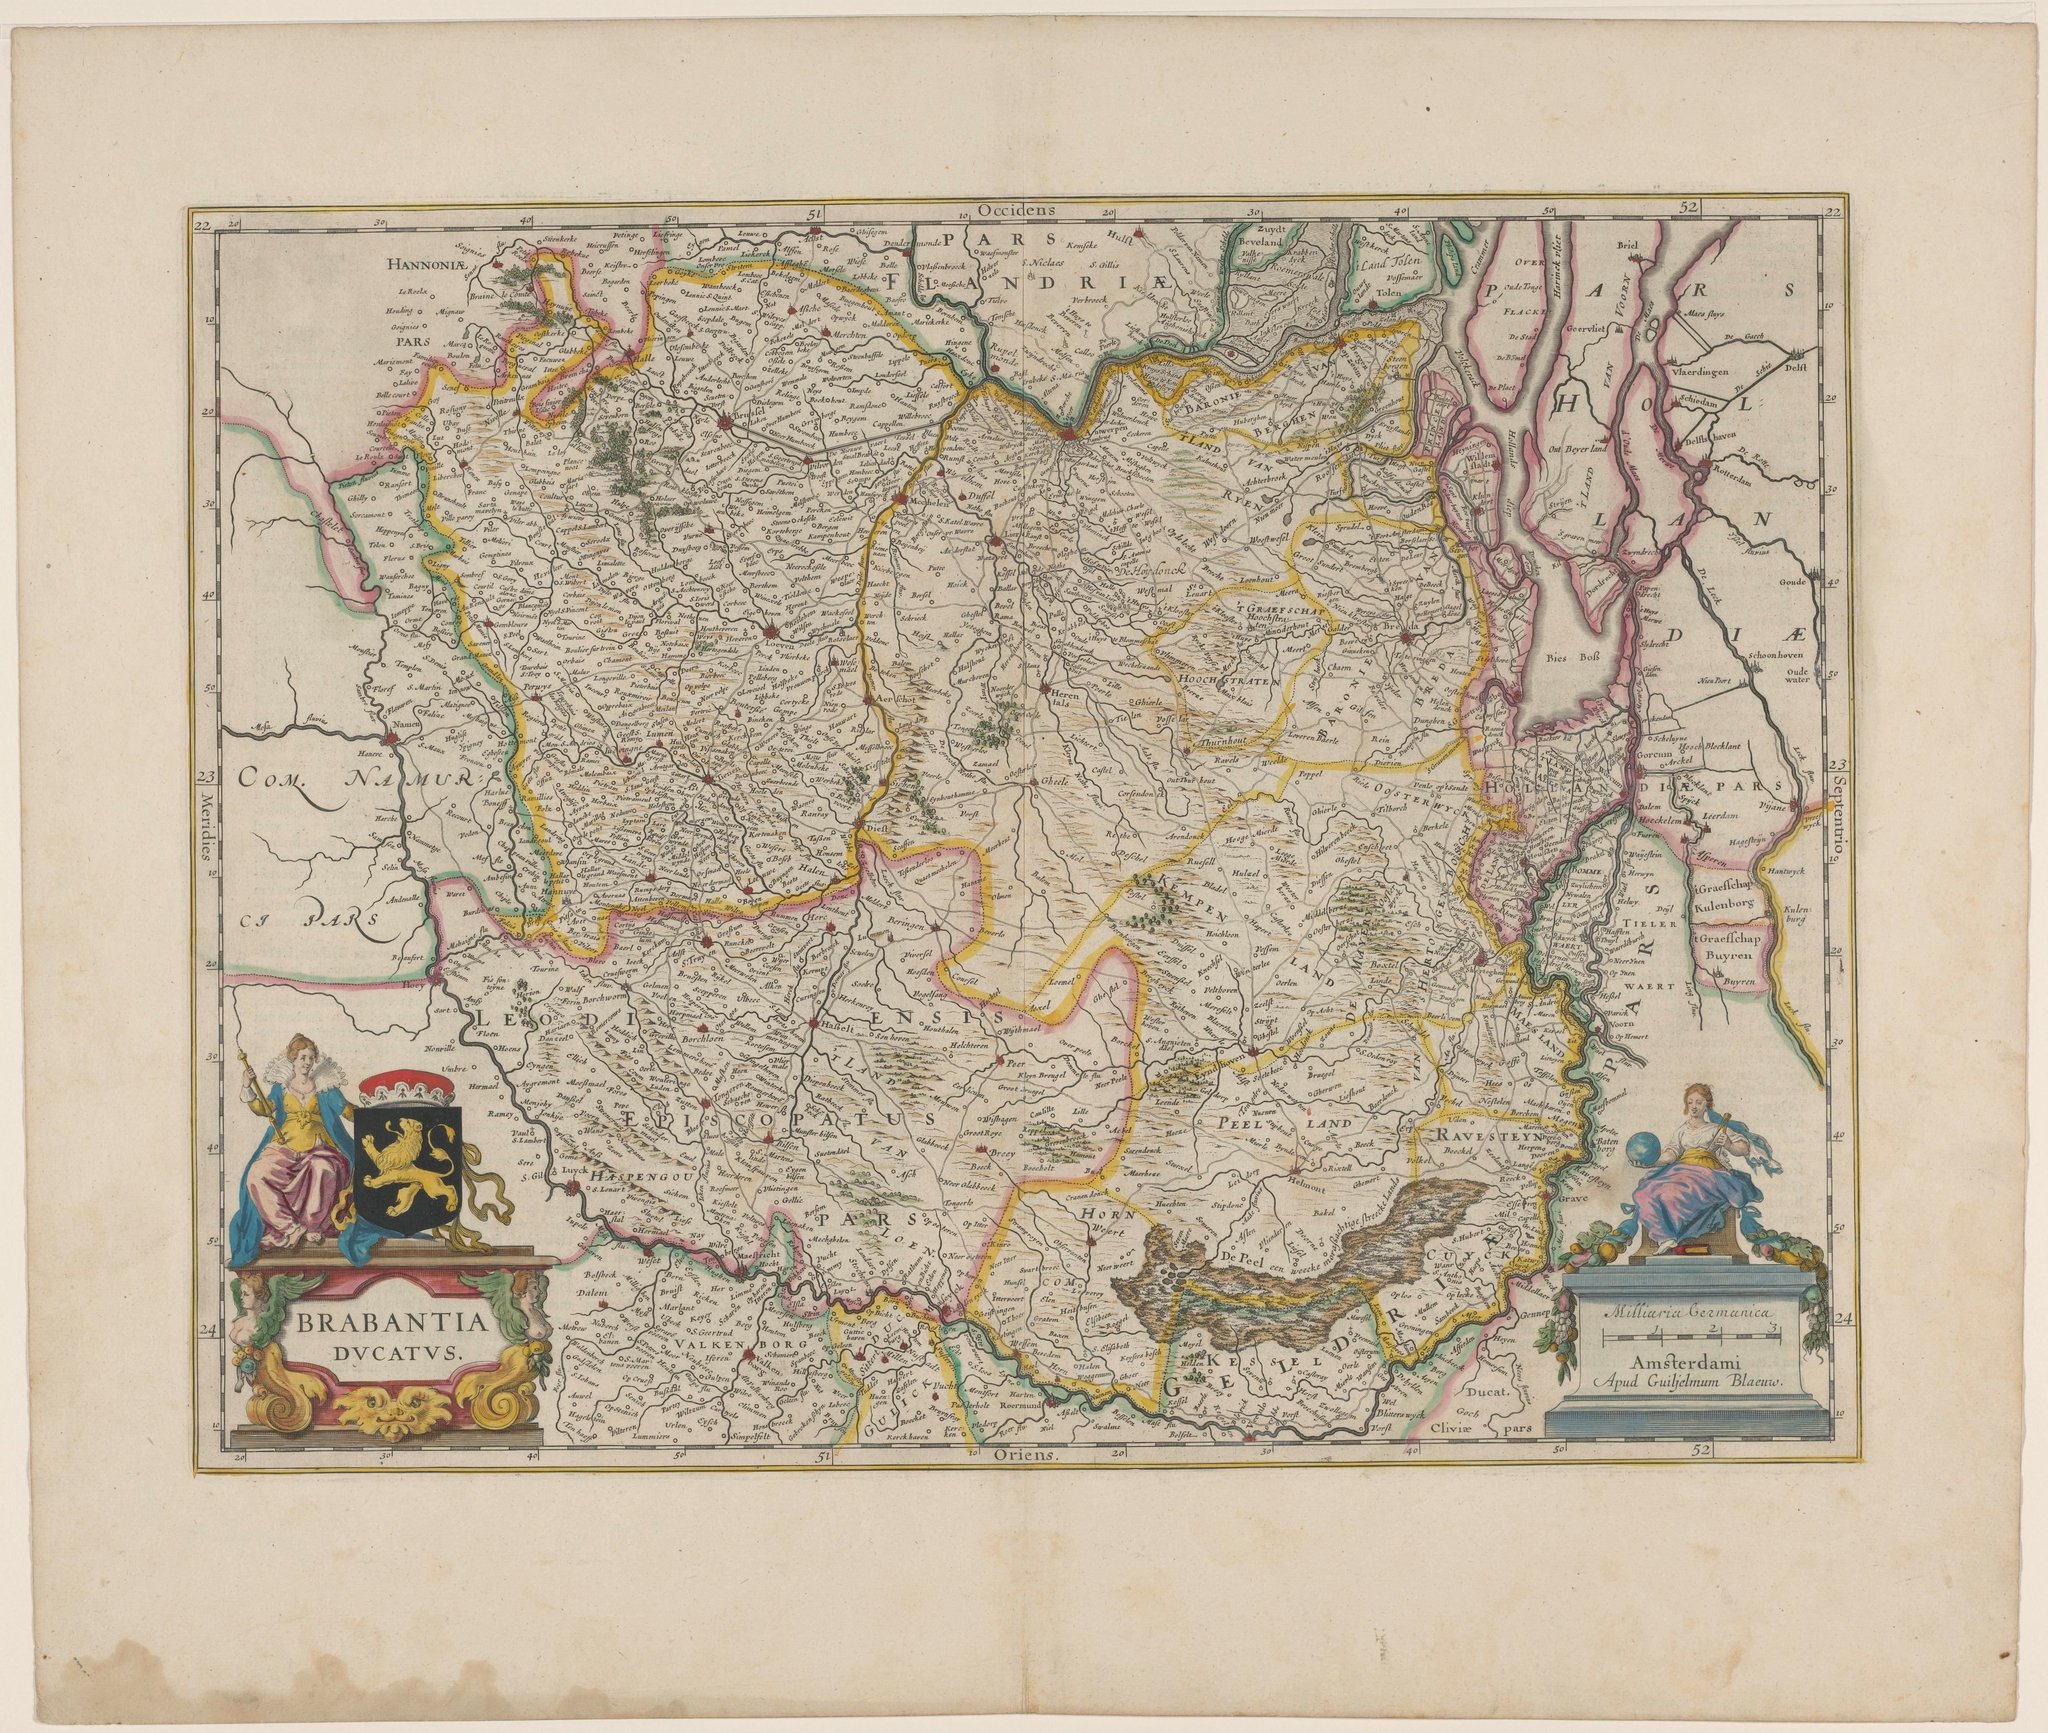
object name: print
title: Kaart van het hertogdom Brabant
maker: Anonymous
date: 1635-1664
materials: paper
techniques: engraving, etching, hand coloring, letterpress printing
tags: maps of separate countries or regions, coat of arms (as symbol of the state, etc.) (+ province; provincial), brabant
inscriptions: collector's mark: Lugt 2228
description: Prent gebruikt in: Blaeu, Willem Janszoon en Johannes Willemszoon Blaeu. Toonneel des aerdriicx, ofte nieuwe Atlas, dat is de beschryving van alle landen. 2 delen. Amsterdam: Willem Janszoon en Johannes Willemszoon Blaeu, 1635, dl. 1. Of in: Blaeu, Willem Janszoon en Johannes Willemszoon Blaeu. Toonneel des aerdriicx, ofte nieuwe Atlas, dat is de beschryving van alle landen. 3 delen. Amsterdam: Cornelis en Johannes Willemszoon Blaeu, 1642-1643, dl. 1 (1642). Of in: Blaeu, Willem Janszoon en Johannes Willemszoon Blaeu. Toonneel des aerdrycx, ofte nieuwe Atlas, dat is de beschryving van alle landen. 4 delen. Amsterdam: Johannes Willemszoon Blaeu, 1647-1650, dl. 1 (1647-1648). Of in: Blaeu, Willem Janszoon en Johannes Willemszoon Blaeu. Toonneel des aerdrycx, ofte nieuwe Atlas, dat is de beschryving van alle landen. 6 delen. Amsterdam: Johannes Willemszoon Blaeu, 1649-1658, dl. 1 (1649). Of in: Blaeu, Willem Janszoon en Johannes Willemszoon Blaeu. Toonneel des aerdrycx, ofte nieuwe Atlas, dat is de beschryving van alle landen. 6 delen. Amsterdam: Johannes Willemszoon Blaeu, 1658-1661, dl. 1 (1659). Of in: Blaeu, Johannes Willemszoon. J. Blaeus grooten atlas oft wereltbeschyving, in welcke 't aerdryck, de zee, en hemel, wort vertoont en beschreven. 9 delen. Amsterdam: Johannes Willlemszoon Blaeu, 1664-1665, dl. 3 (1664).